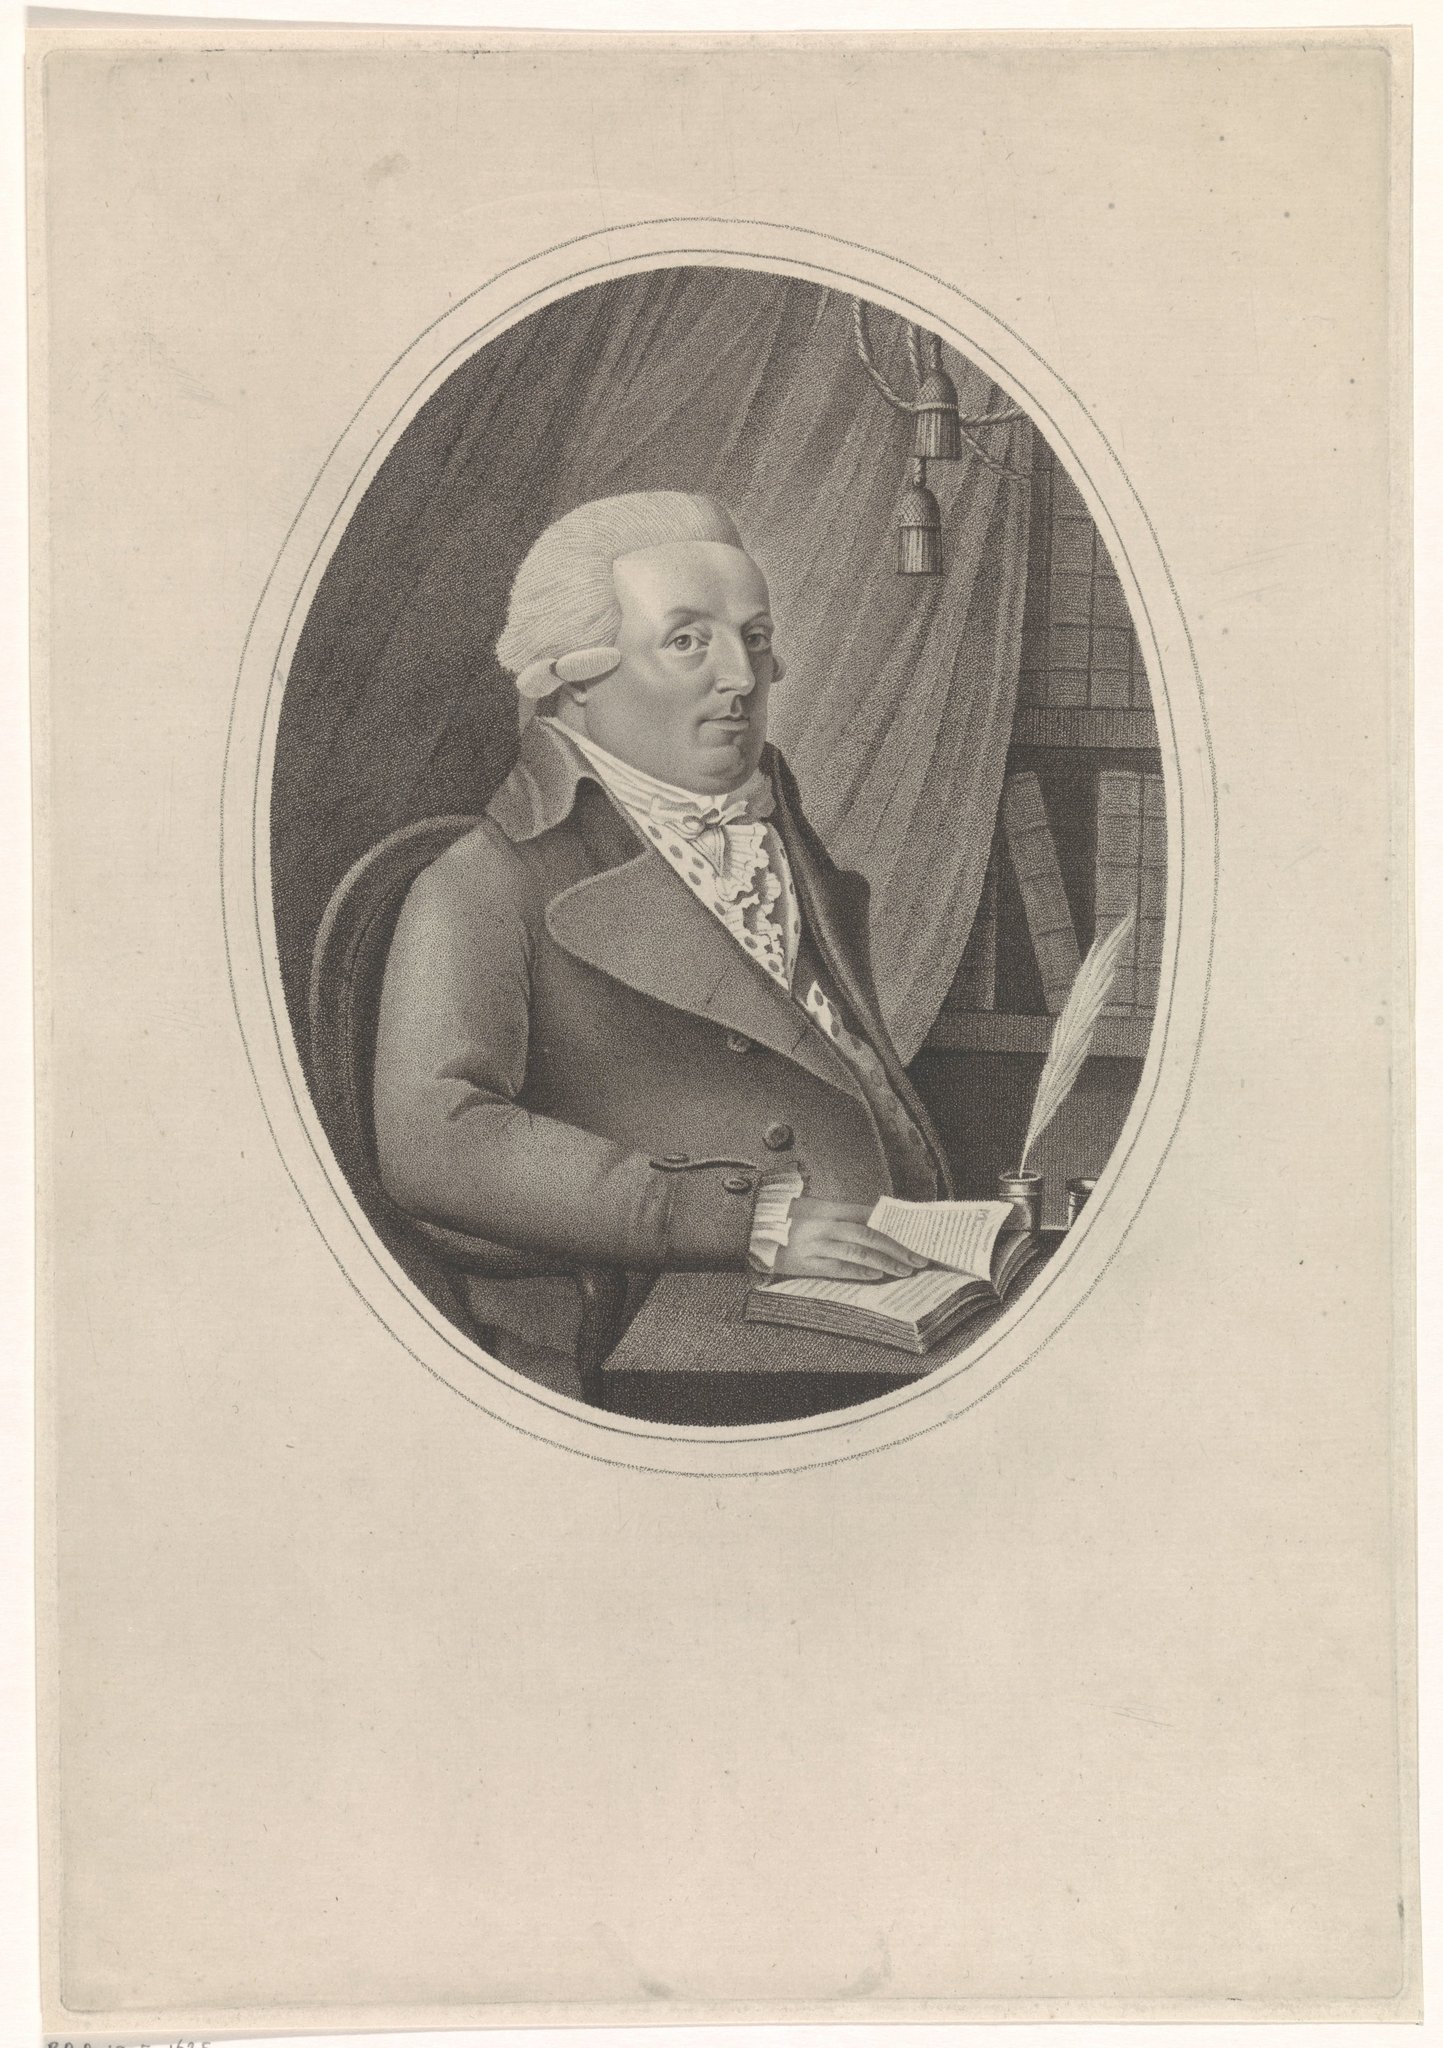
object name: print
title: Portret van Jacobus Johannes Schrijver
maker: govert kitsen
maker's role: print maker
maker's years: 1766-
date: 1796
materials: paper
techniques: engraving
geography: rotterdam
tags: book - mm - book open, writing accessories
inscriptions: collector's mark: Lugt 2228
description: Portret van Jacobus Johannes Schrijver, baljuw te Rotterdam. Hij zit aan een bureau waarop een schrijfveer en een inktpot staan en heeft de rechterhand op een opengeslagen boek gelegd.